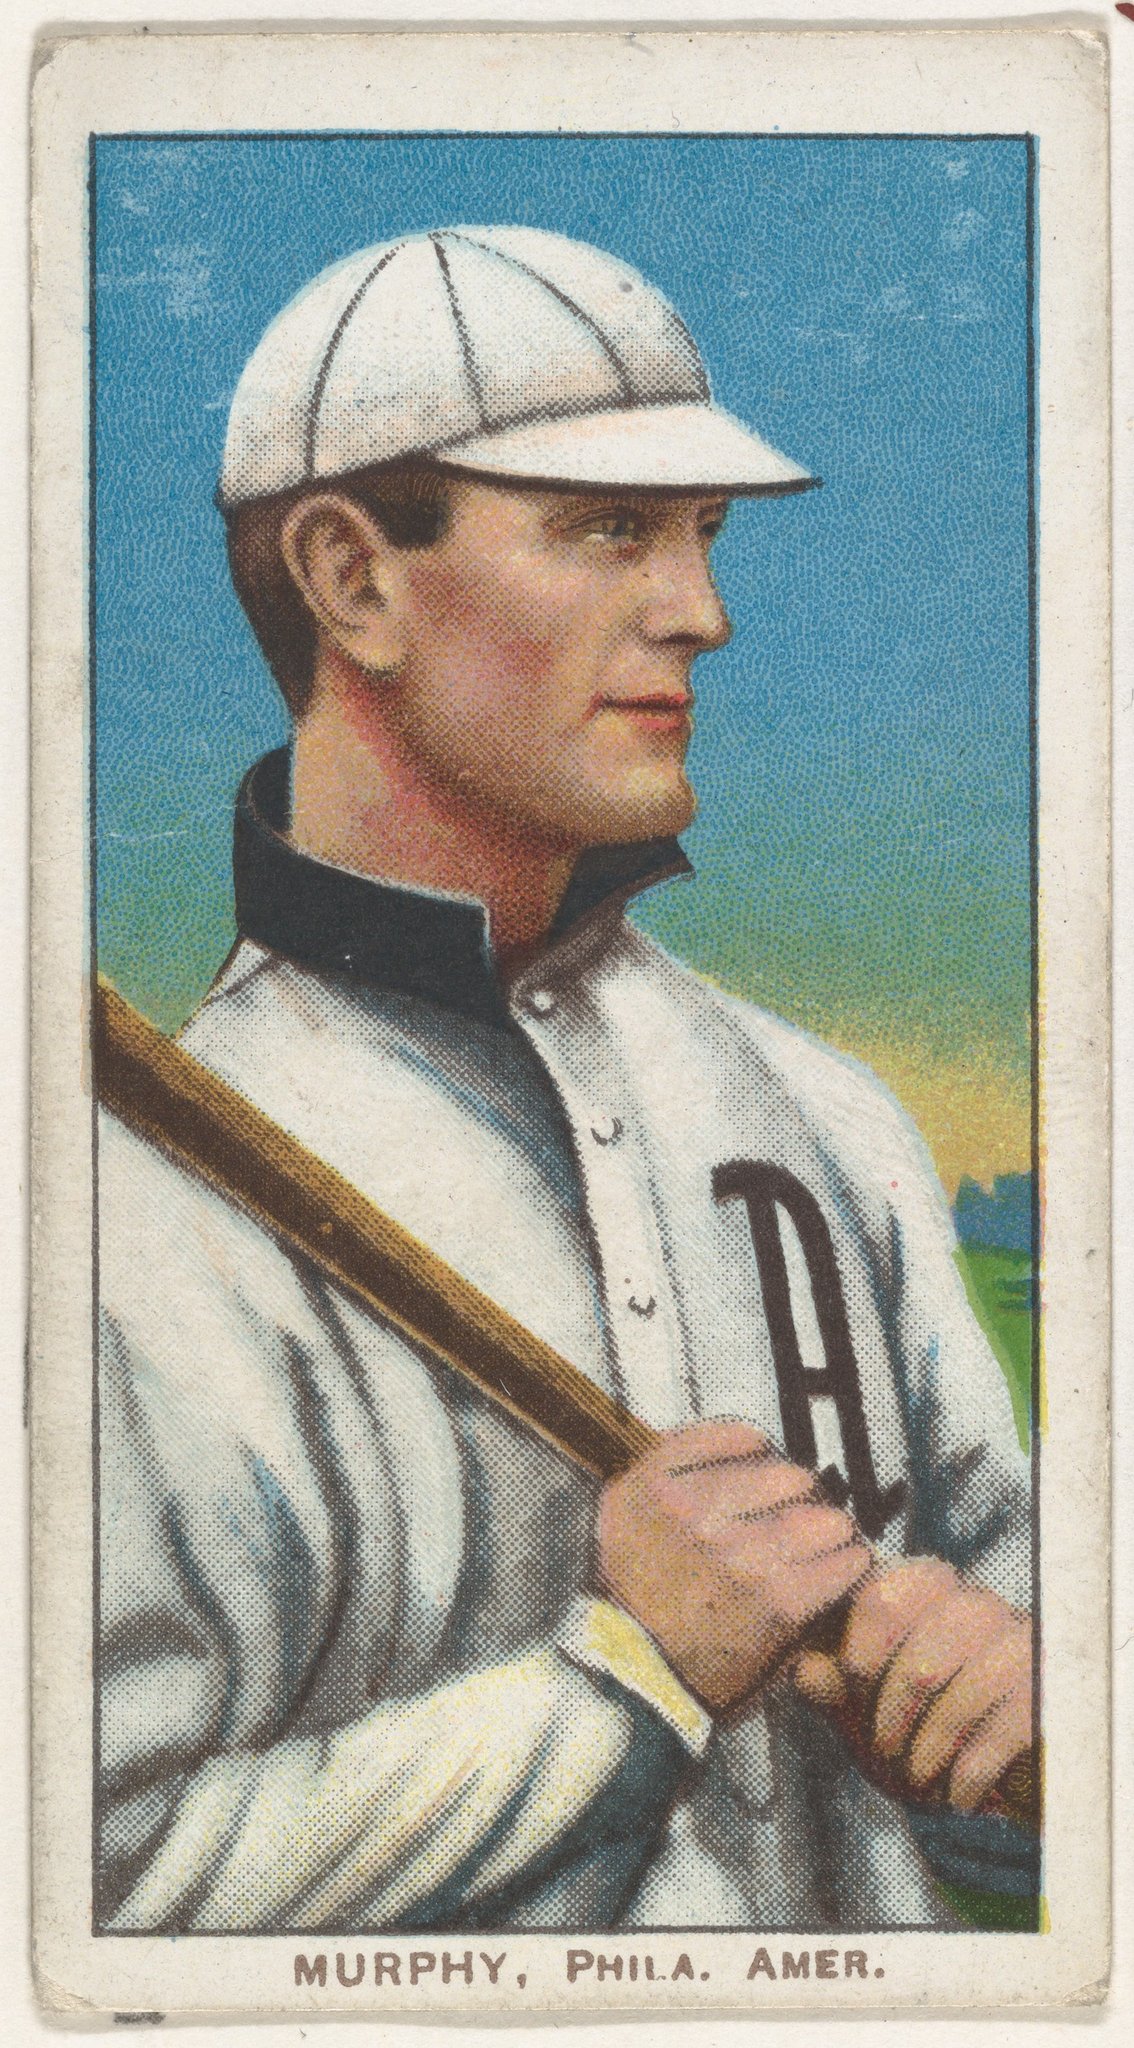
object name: baseball card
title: Murphy, Philadelphia, American League, from the White Border series (T206) for the American Tobacco Company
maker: american tobacco company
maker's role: publisher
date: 1909-1911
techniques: color lithograph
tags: men,baseball,athletes